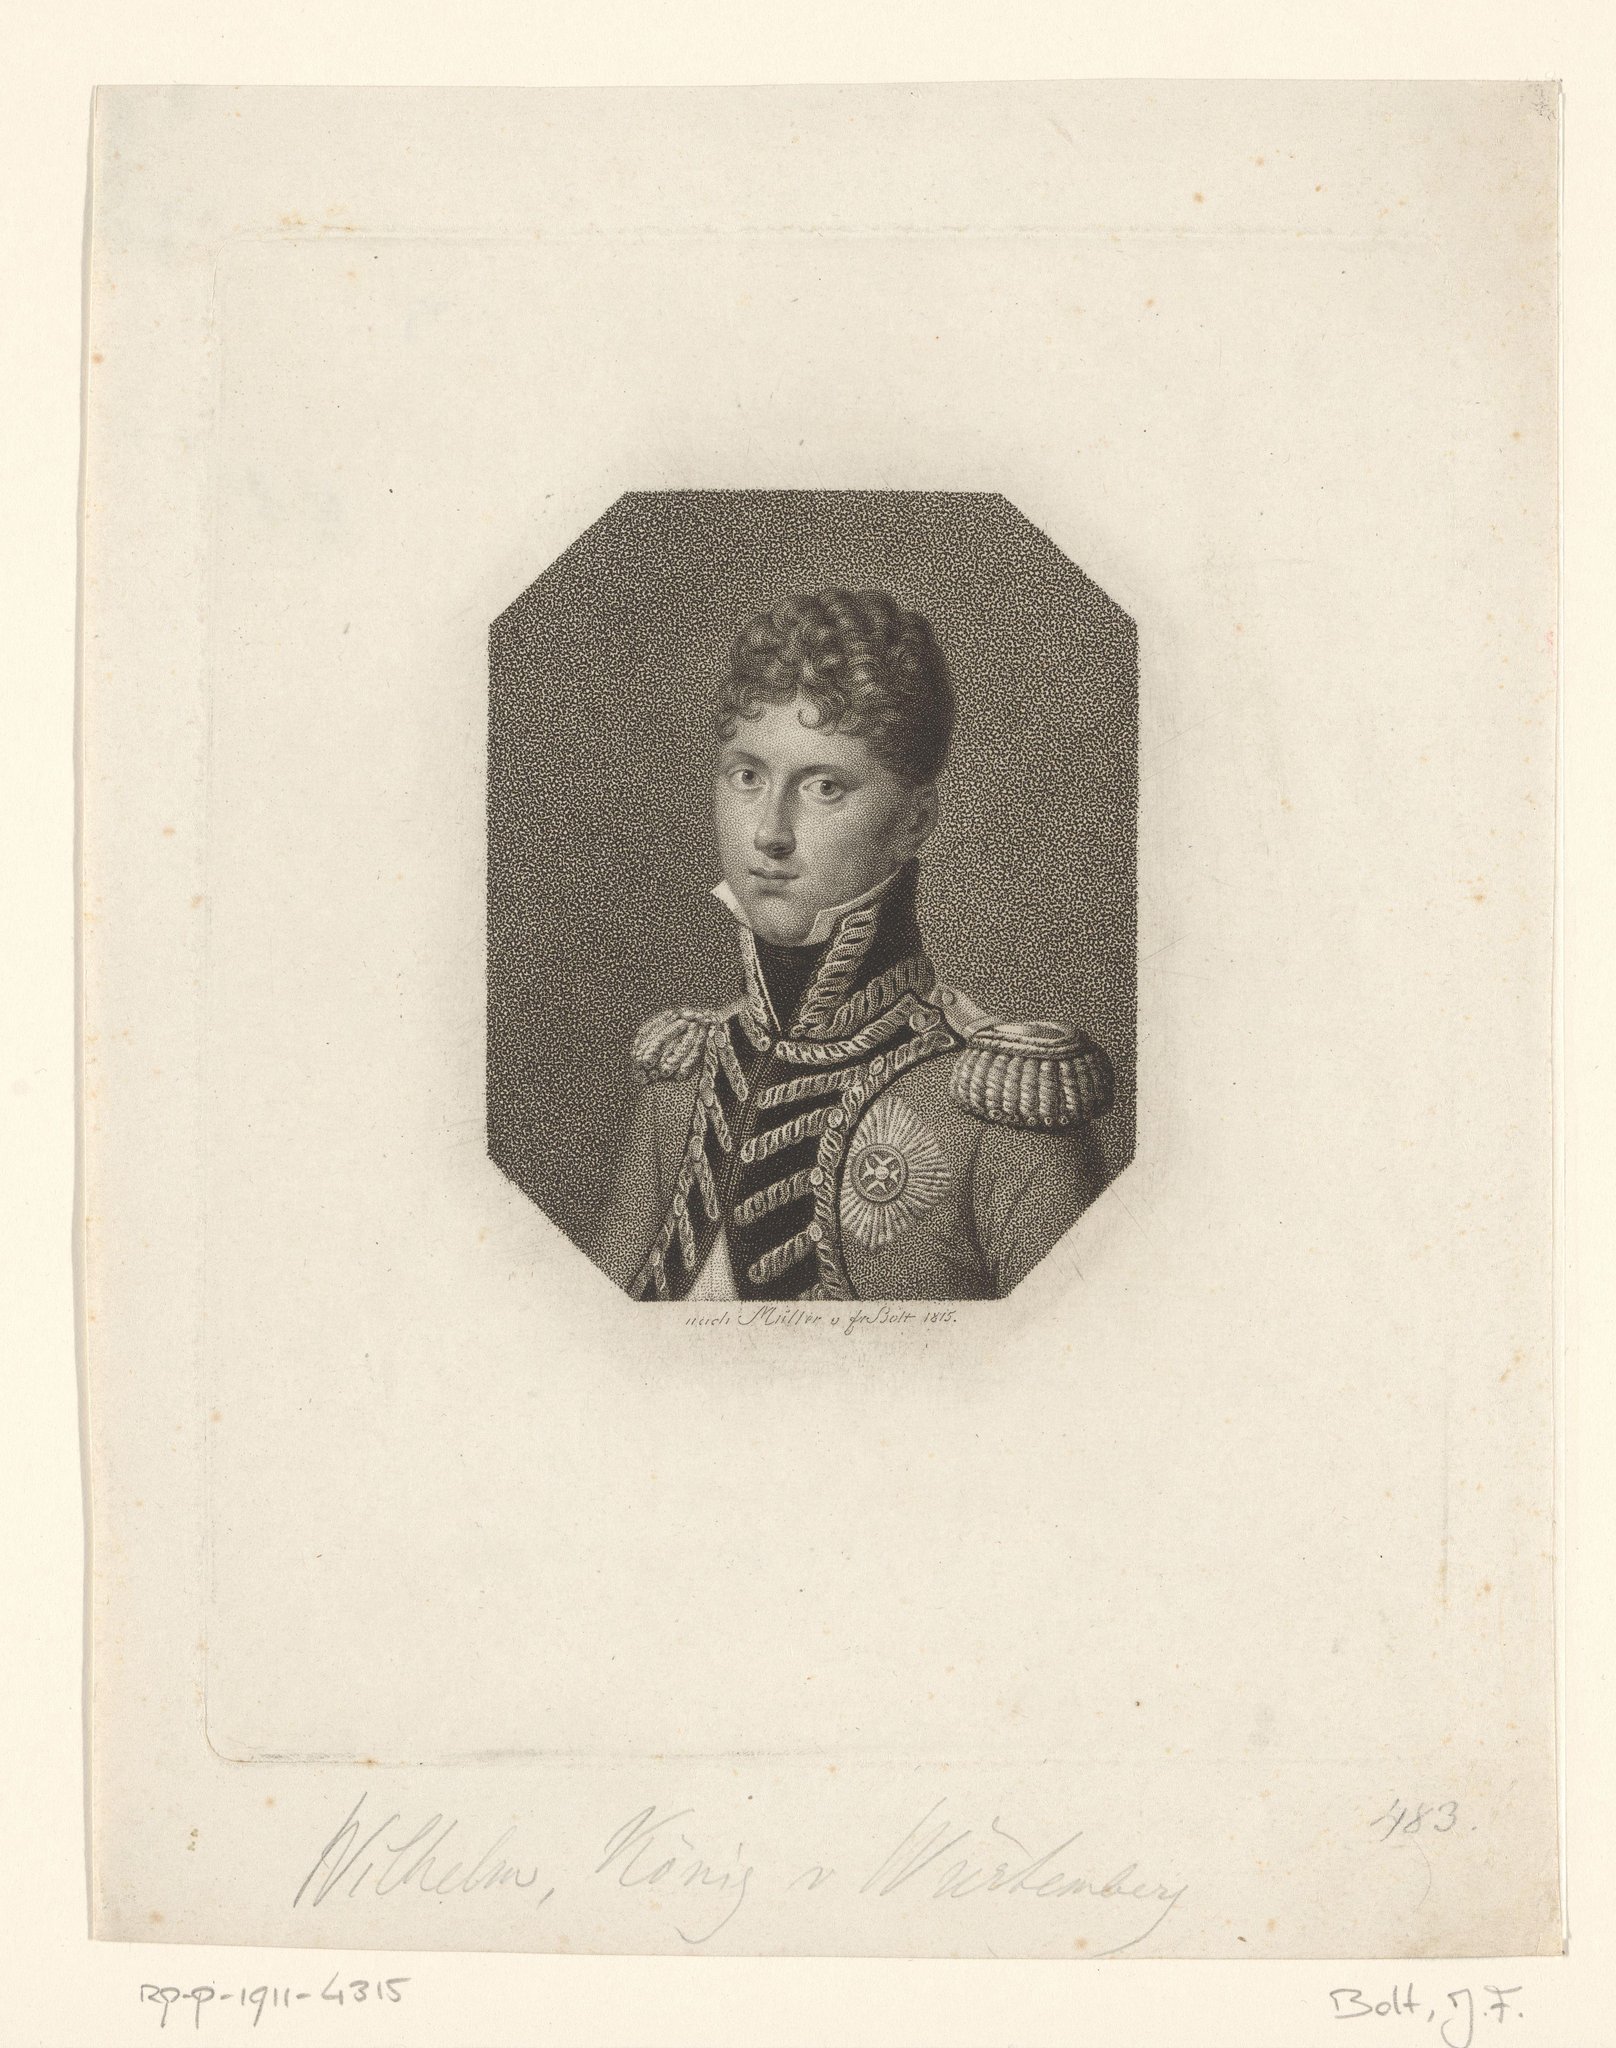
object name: print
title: Portret van Willem I, koning van Württemberg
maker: johann friedrich bolt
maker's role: print maker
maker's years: 1769-1836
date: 1792-1816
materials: paper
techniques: engraving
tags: willem i koning van württemberg, historical persons, medals and other marks of military honour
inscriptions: collector's mark: Lugt 2228